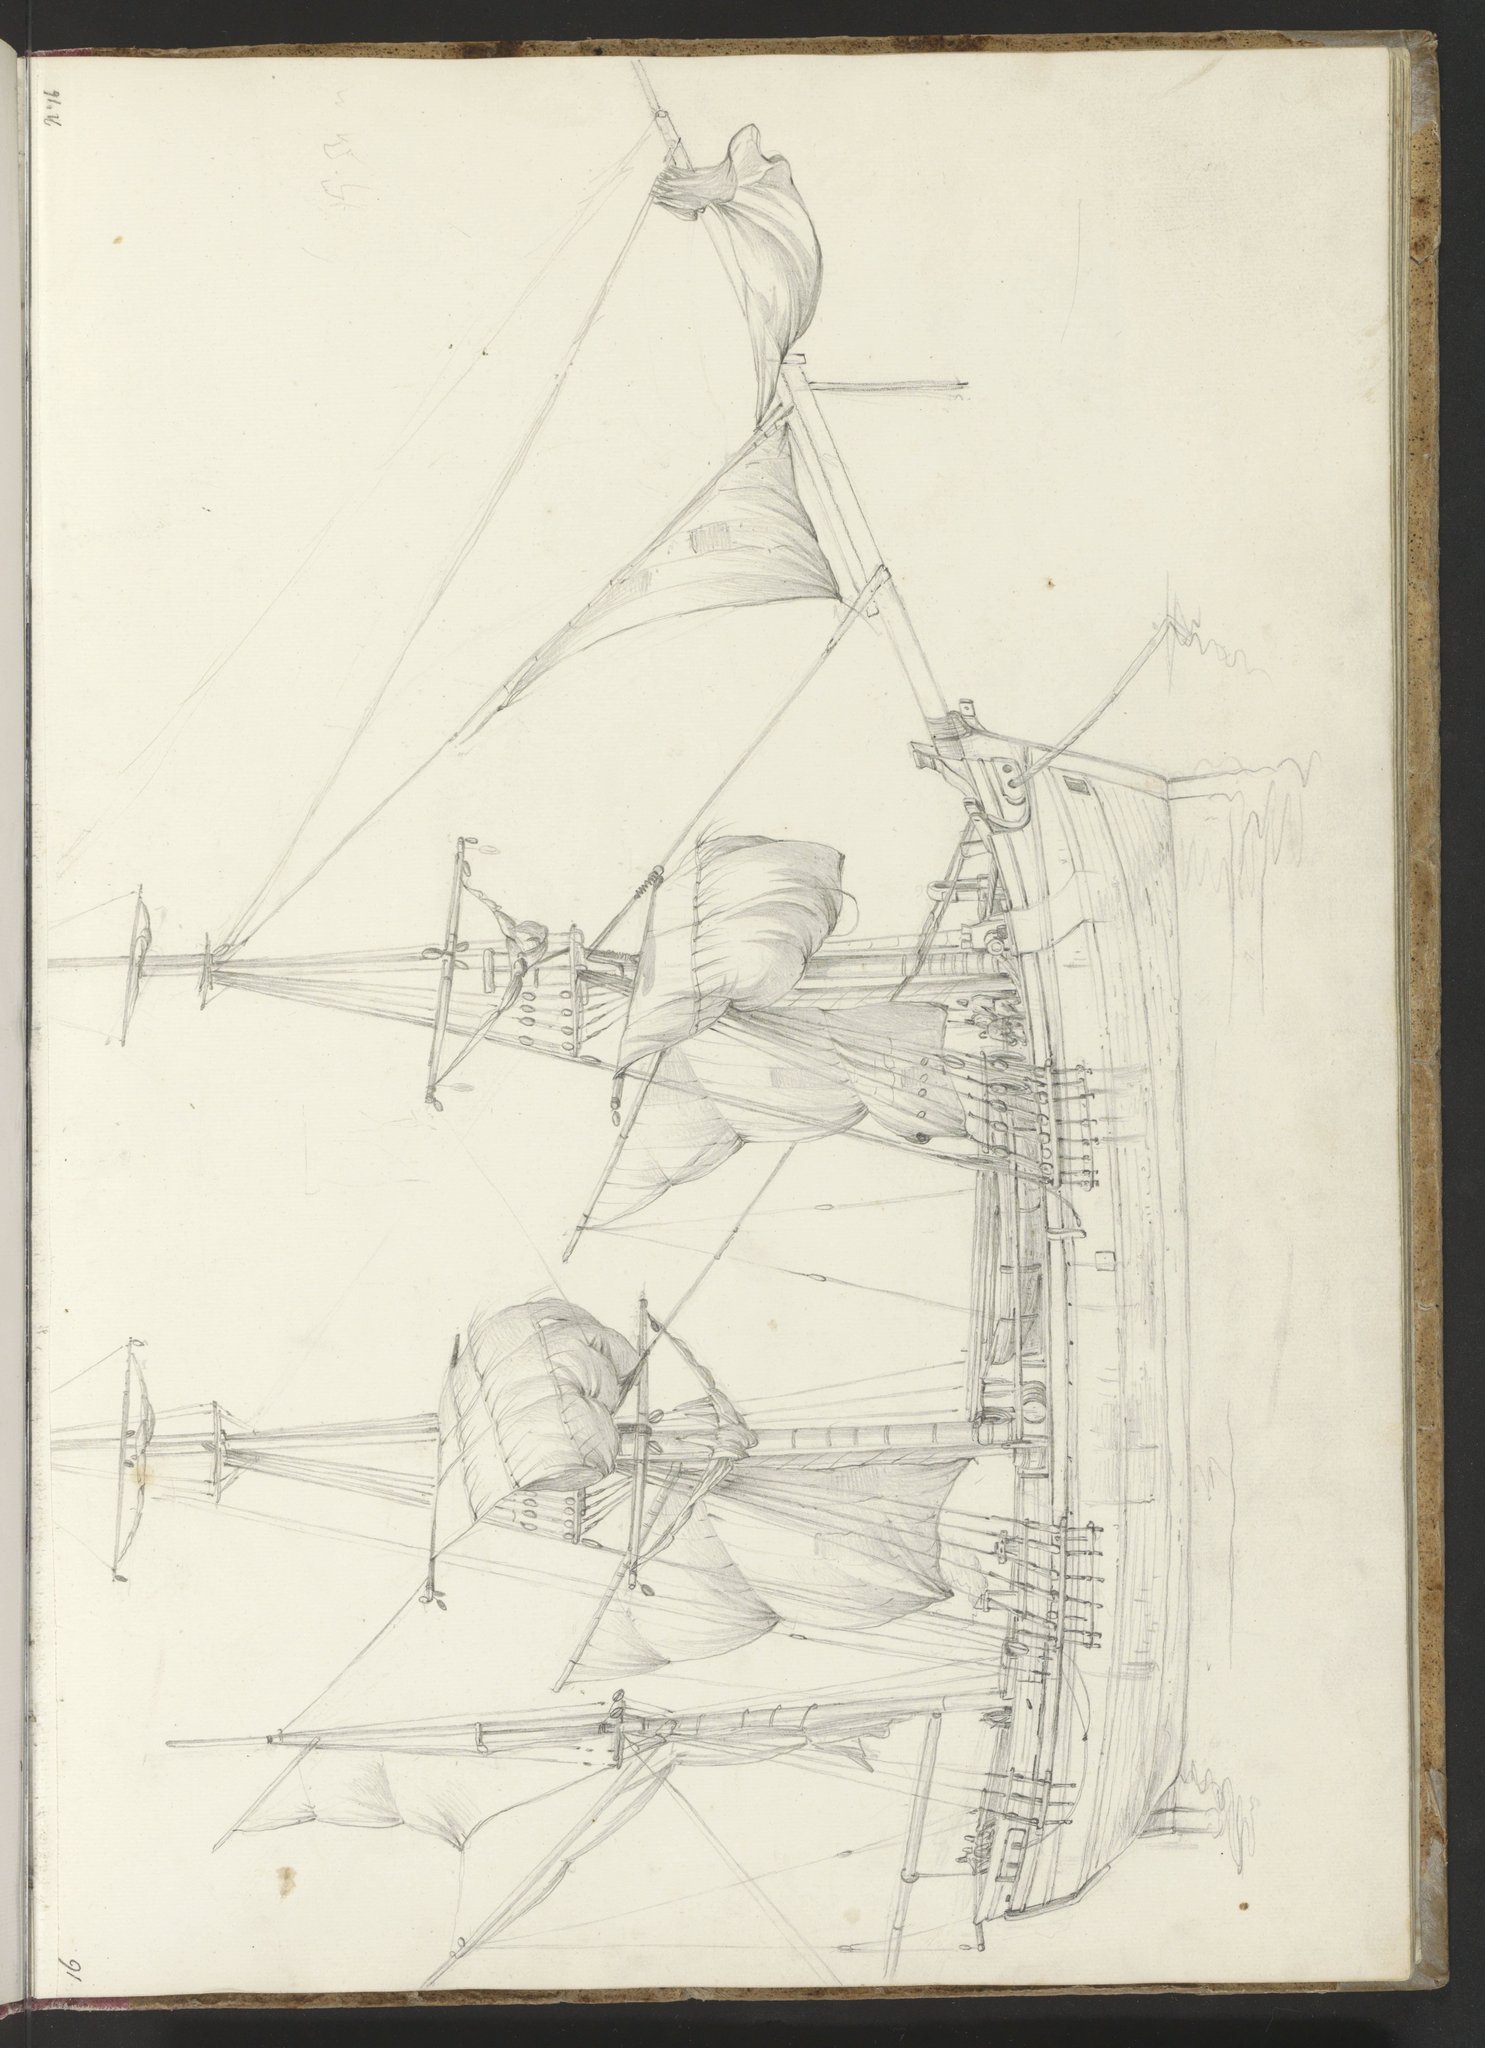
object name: sketchbook leaf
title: Driemaster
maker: johannes christiaan schotel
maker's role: draughtsman, painter, print maker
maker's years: 1787-1838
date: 1797-1838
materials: paper, pencil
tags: sailing-ship, sailing-boat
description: Blad 16 recto uit een schetsboek met 65 bladen.